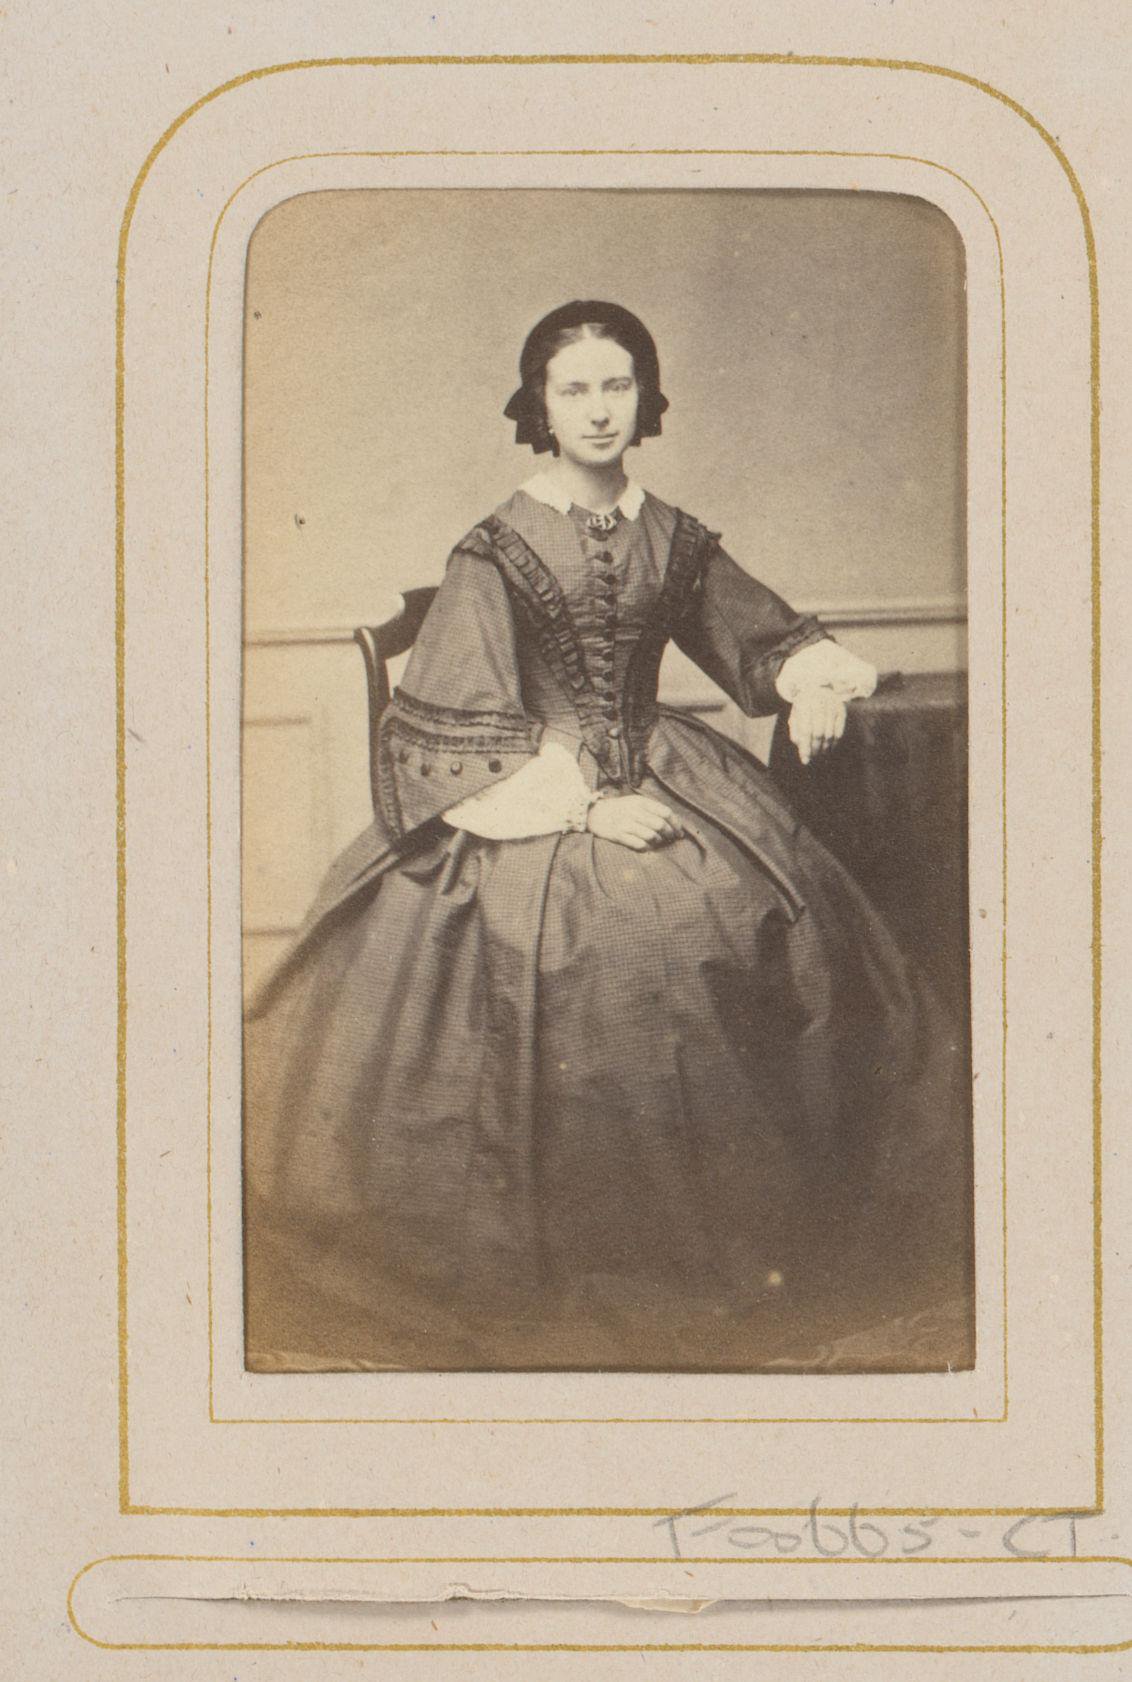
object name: carte de visite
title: Portret van een vrouw zittend bij een tafel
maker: wilhelm frederick antonius delboy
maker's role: fotograaf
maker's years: 1853-1928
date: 1860-1890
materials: cardboard, photographic support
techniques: albumen print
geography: the hague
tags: historical persons - bb - woman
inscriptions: inscription: ‘Delboy/ Photographie/ Gortstraat/ 's Hage’